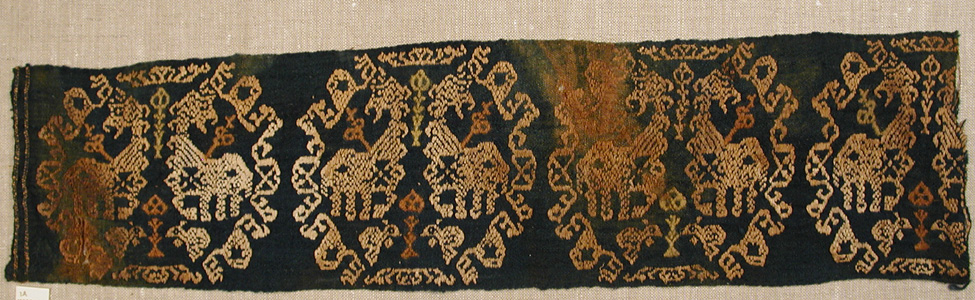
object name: textile fragment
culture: byzantine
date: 601-900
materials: linen, wool